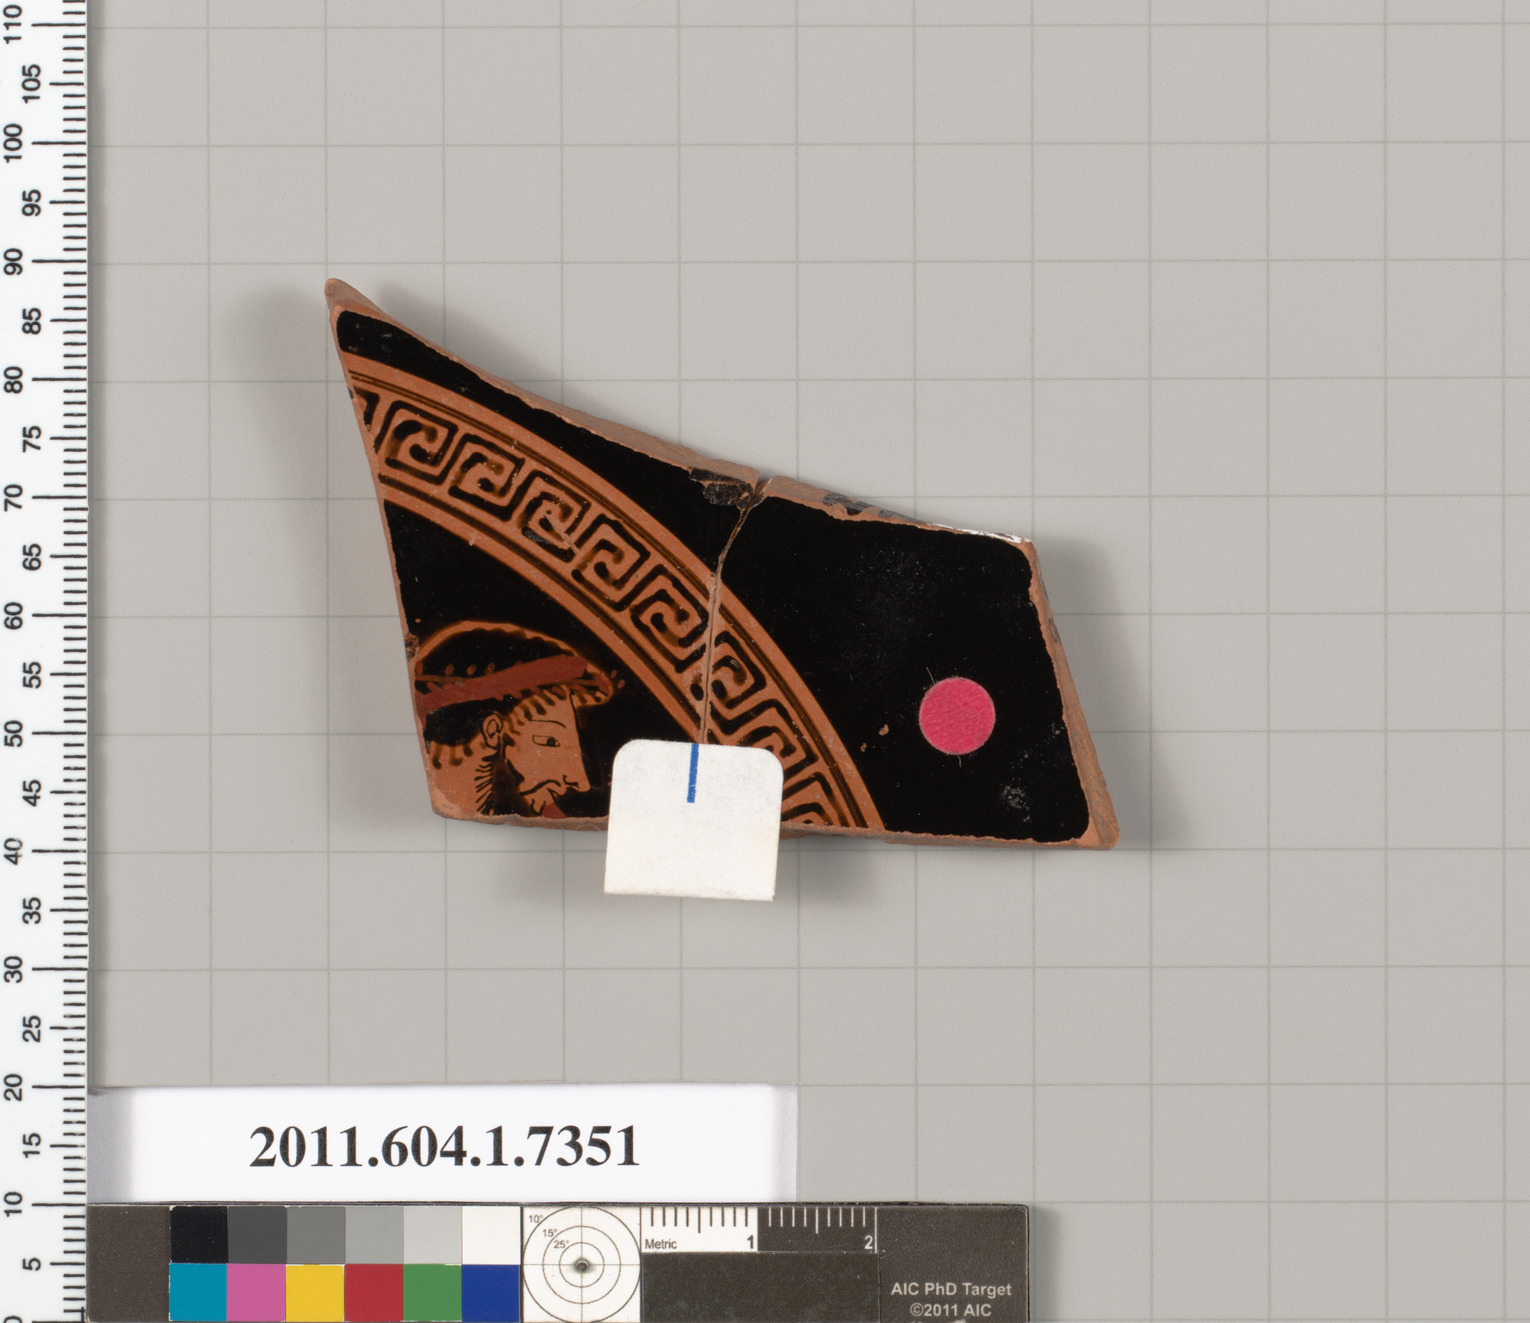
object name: kylix fragment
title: Terracotta fragment of a kylix (drinking cup)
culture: greek, attic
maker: makron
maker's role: artist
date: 500-480 BCE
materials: terracotta